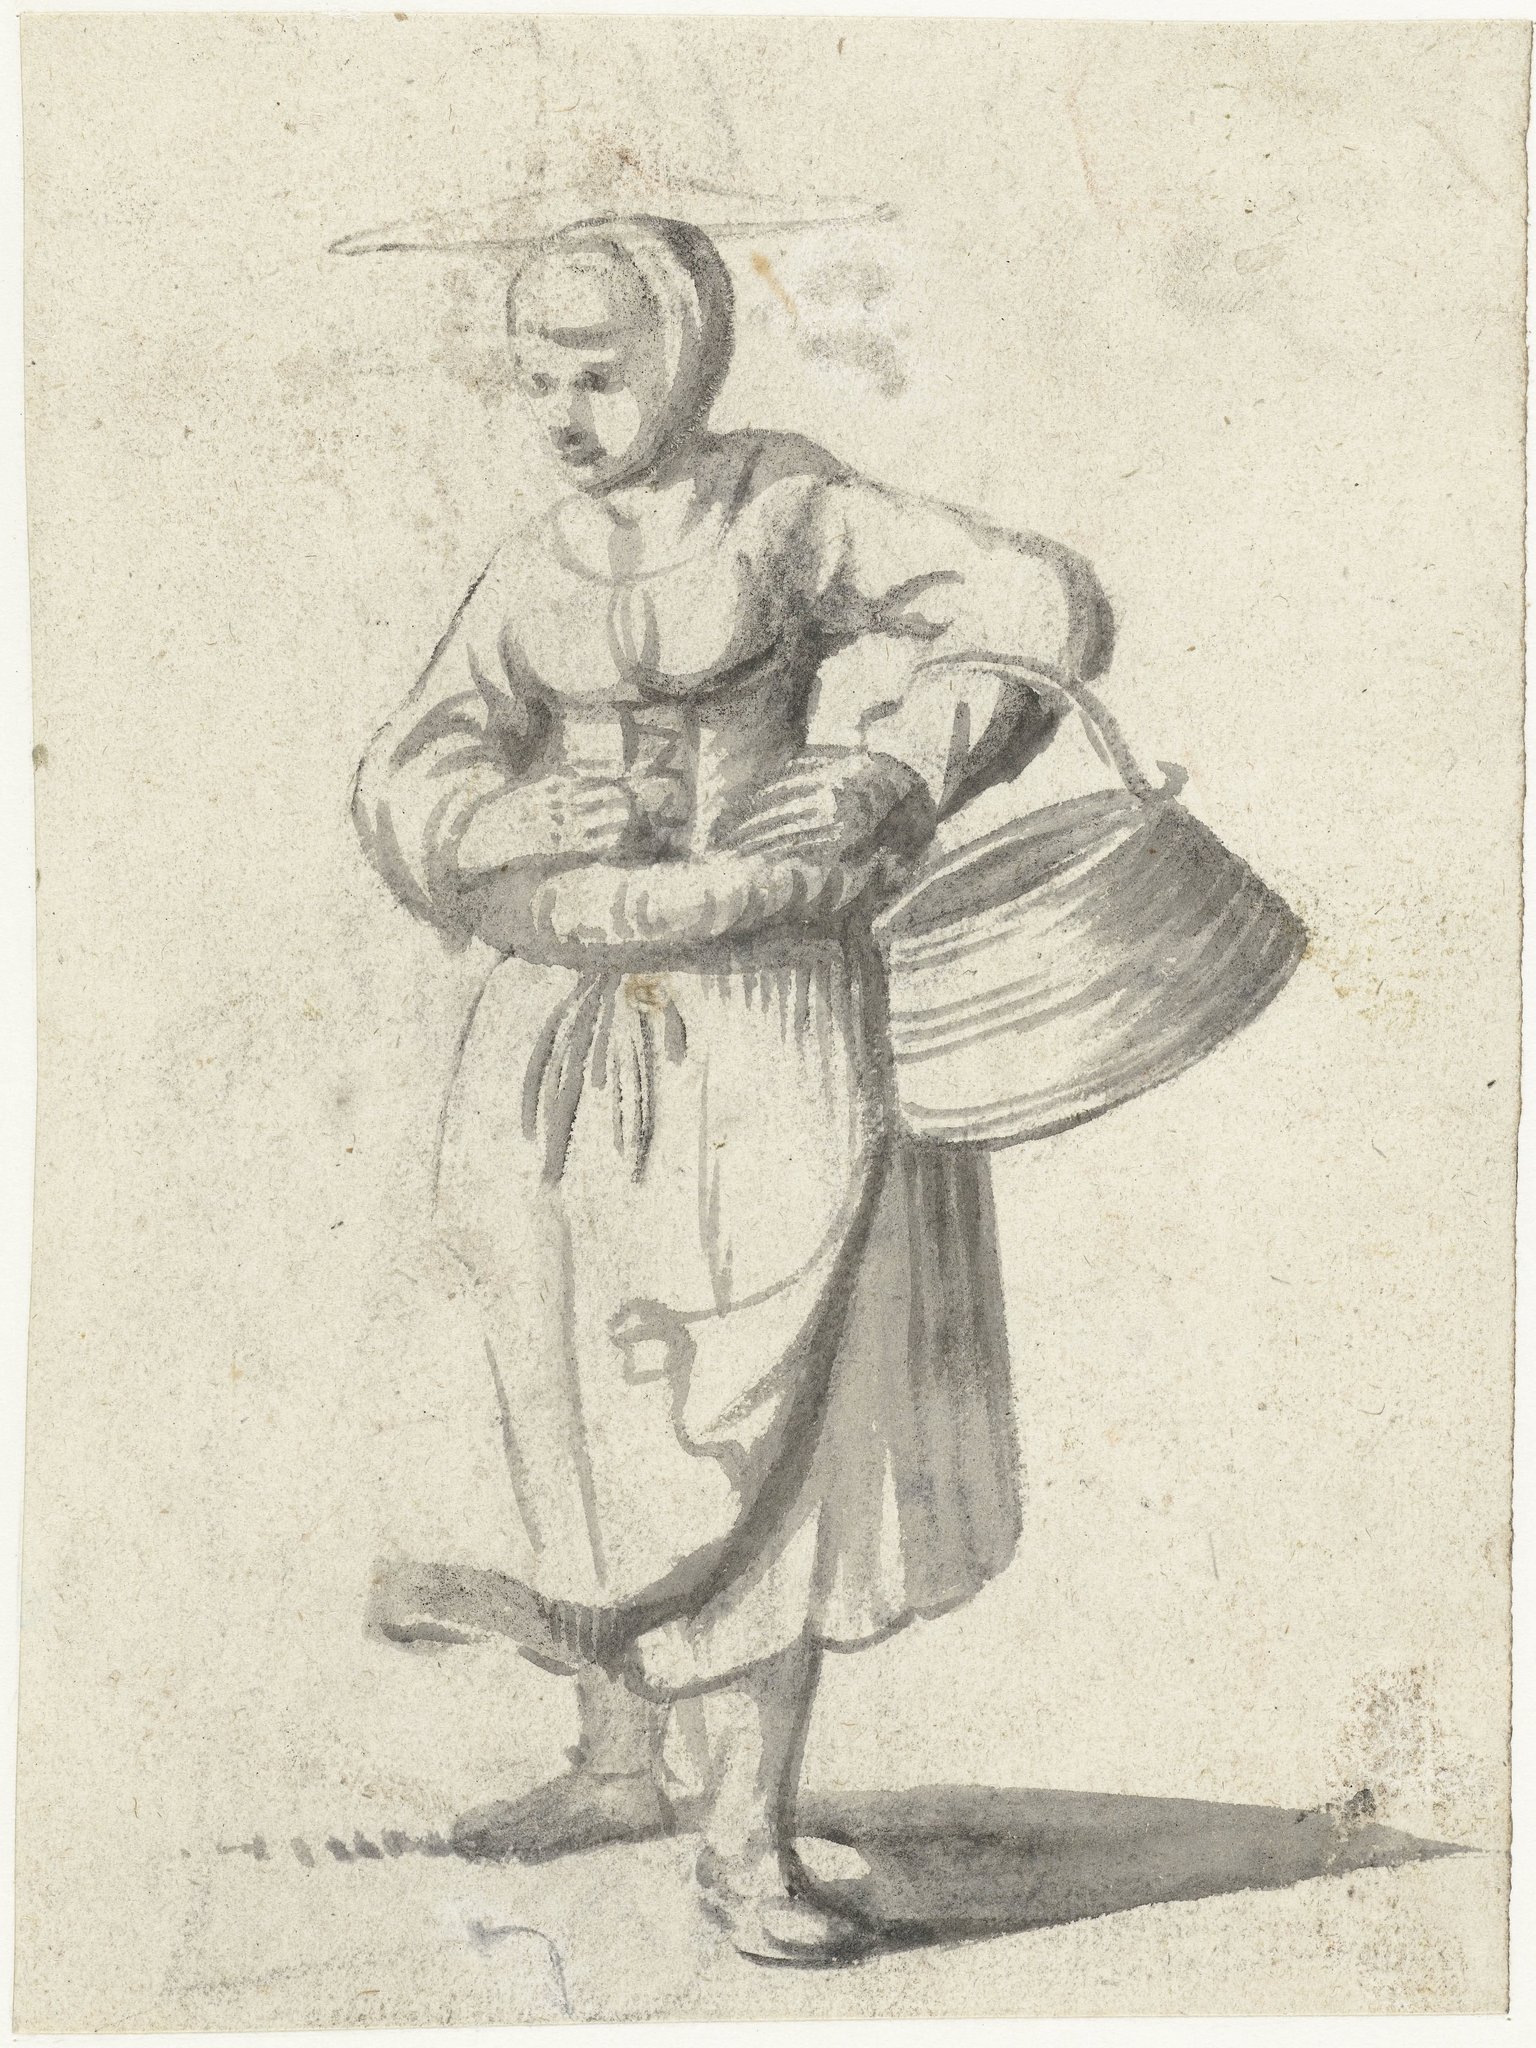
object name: drawing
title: Vrouw met een strohoed en een emmer aan haar arm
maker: harmen ter borch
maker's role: draughtsman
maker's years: 1638-1677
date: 1652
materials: chalk, ink, paper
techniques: brush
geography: zwolle